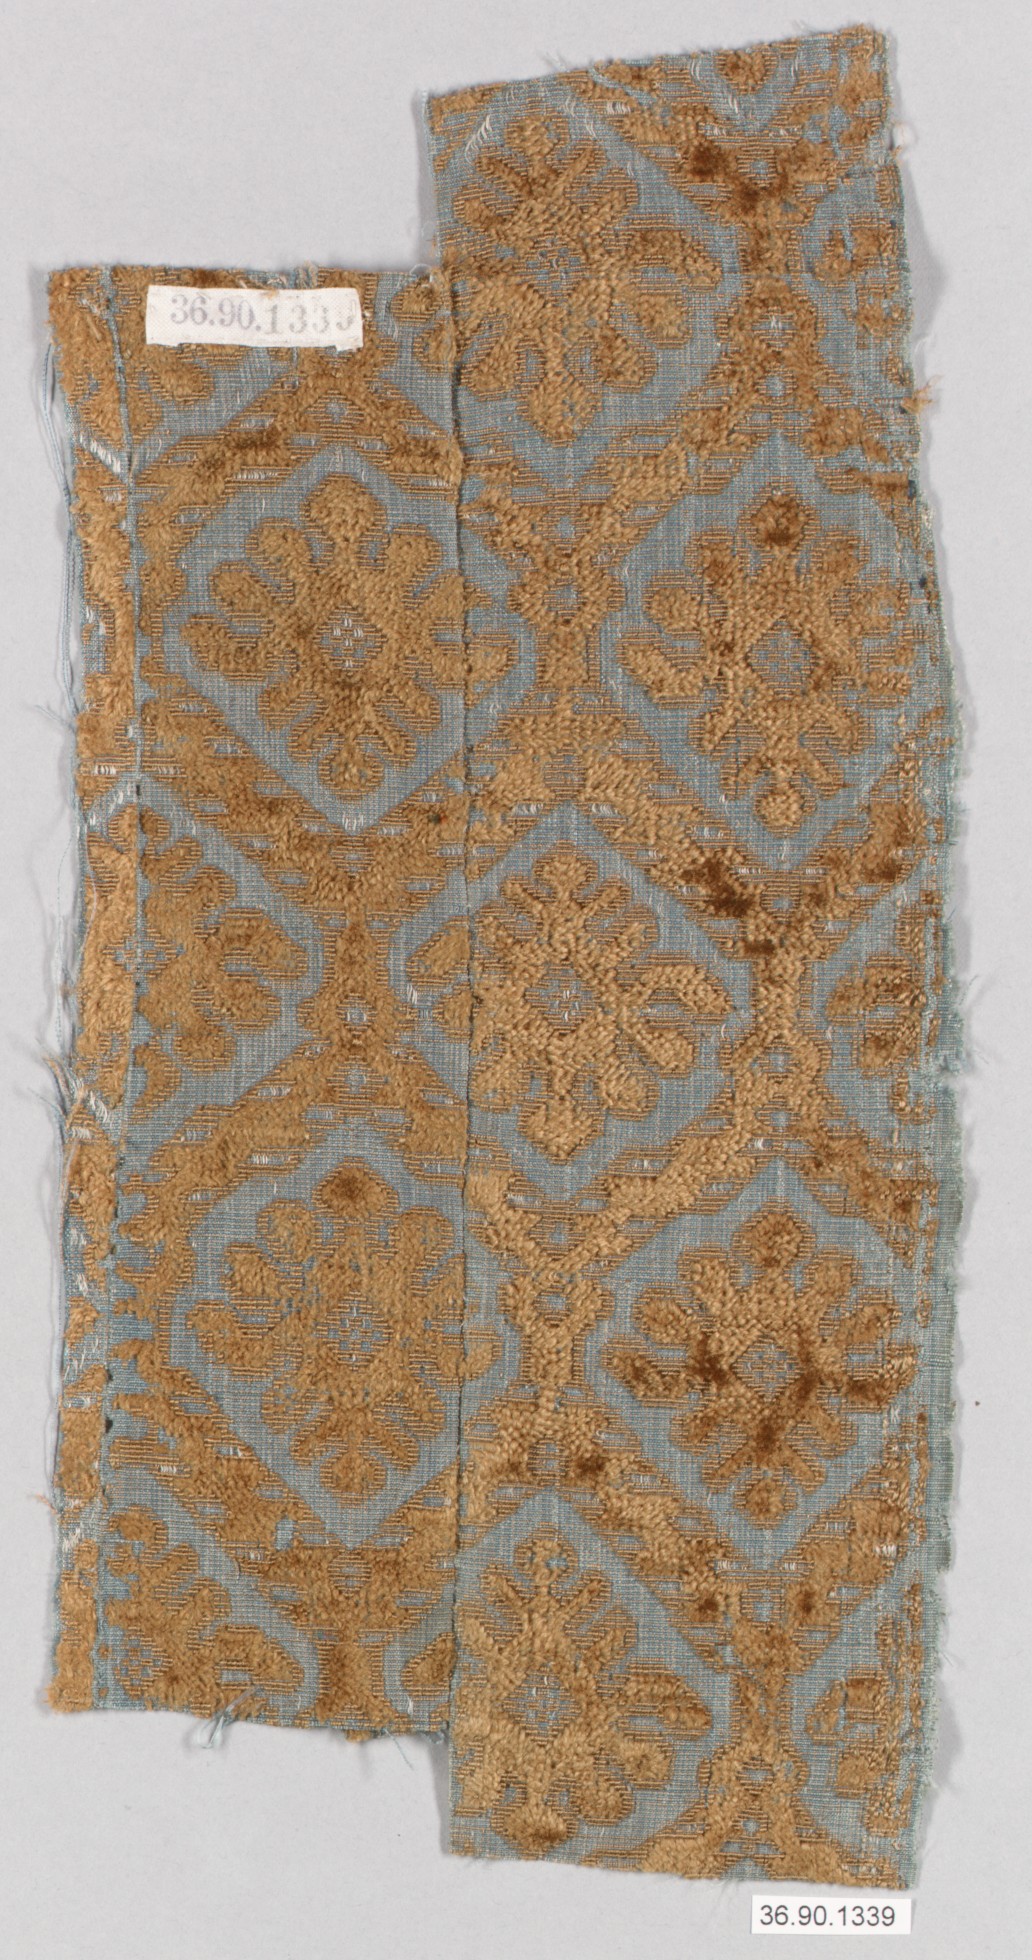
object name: piece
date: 1501-1700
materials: silk